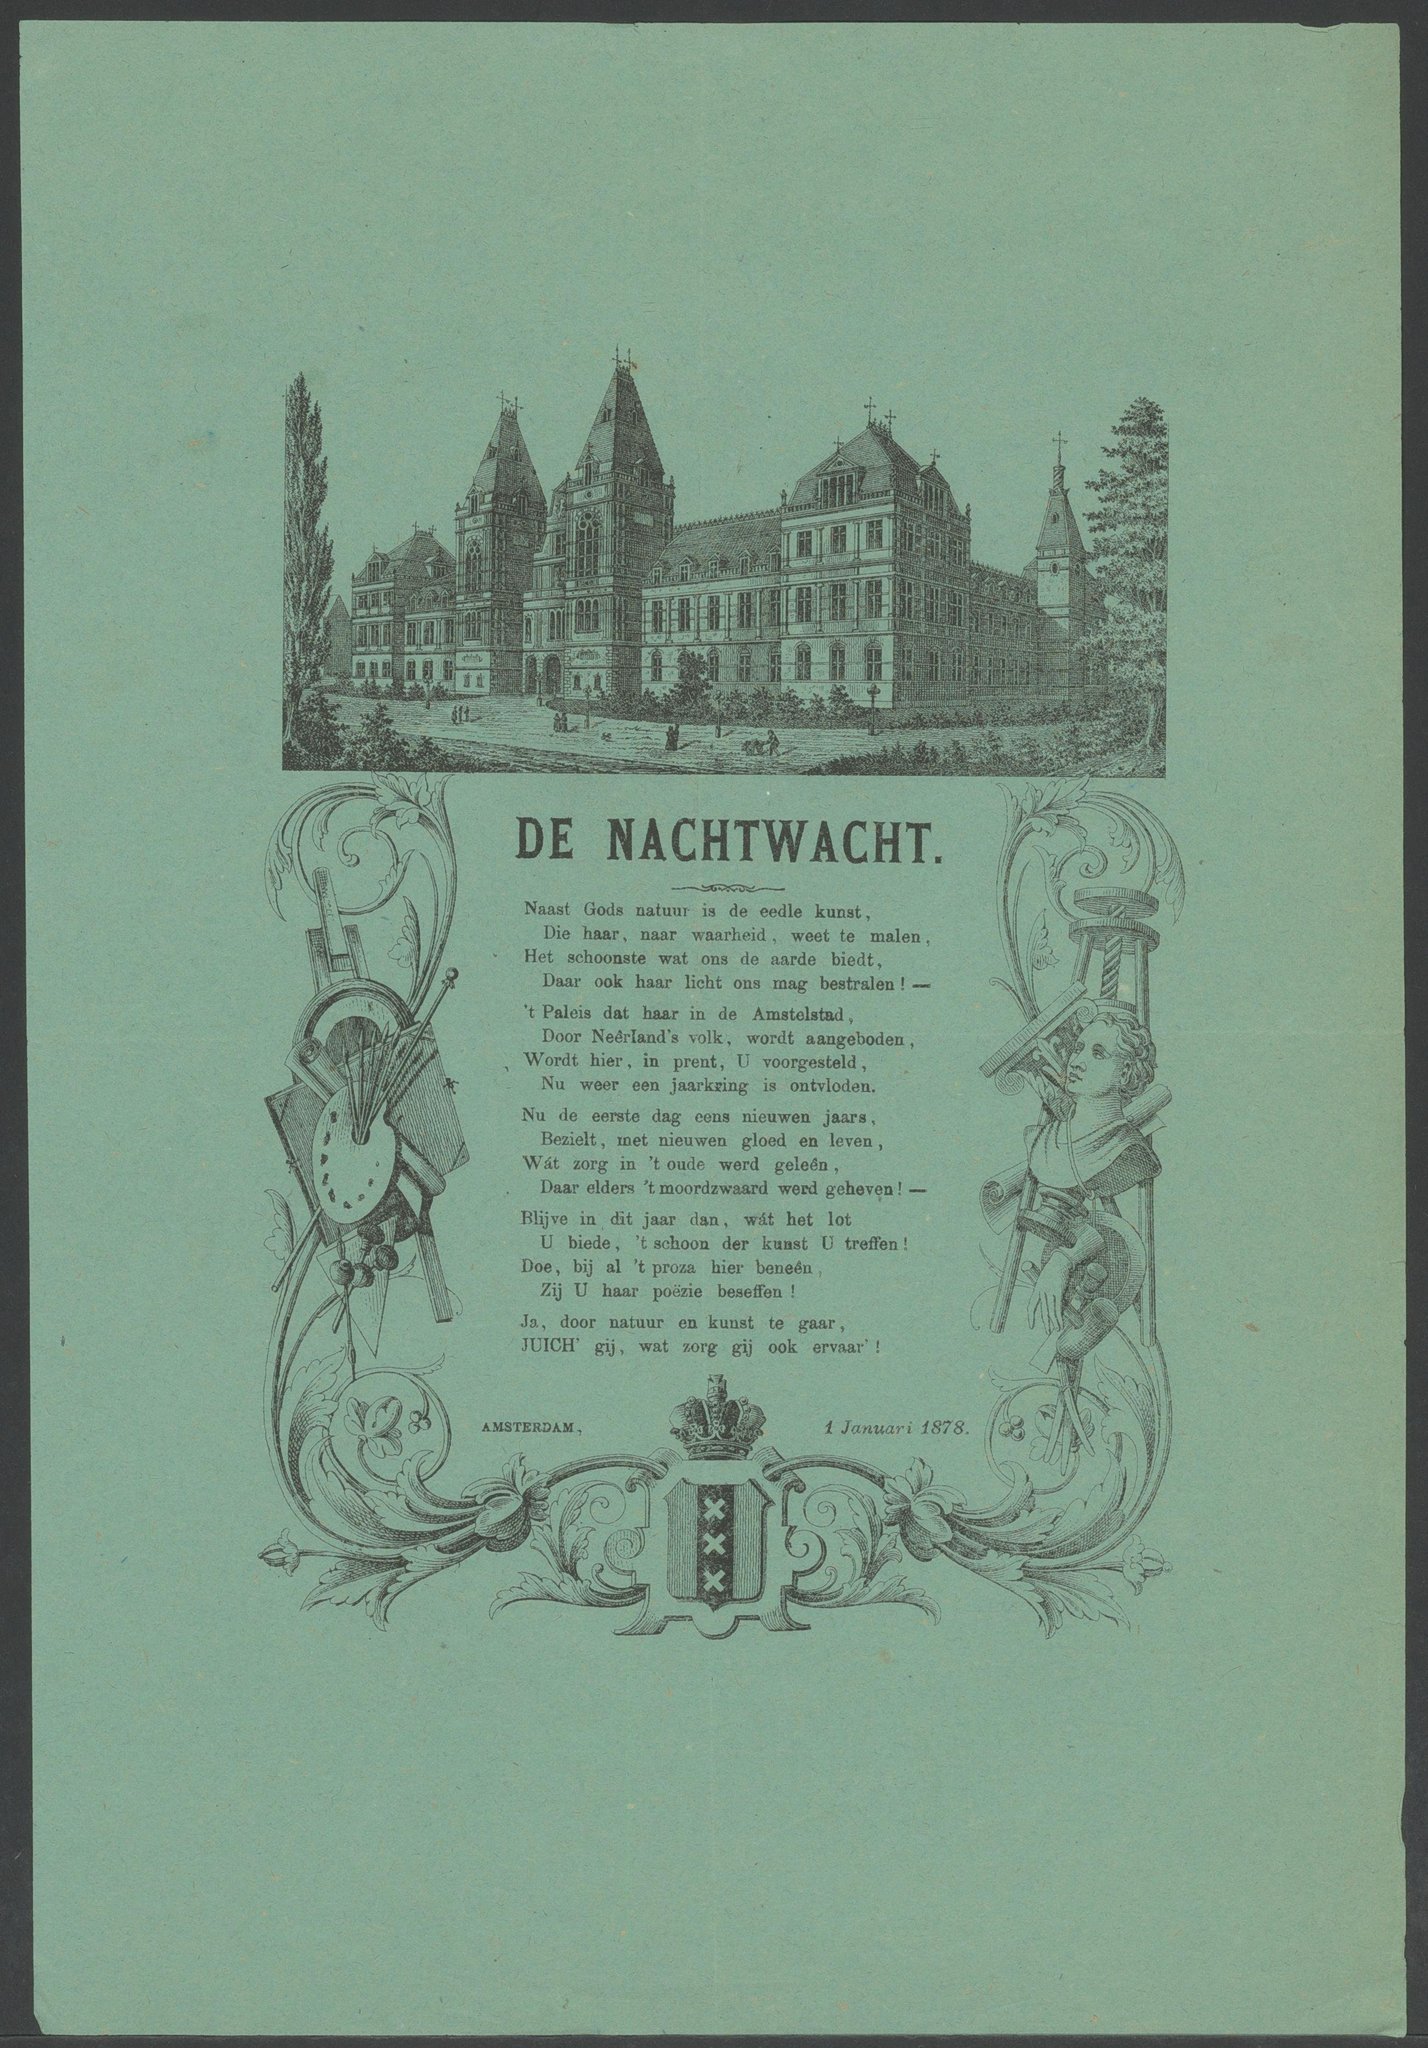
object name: print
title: Nieuwjaarswens van de Amsterdamse nachtwacht voor het jaar 1878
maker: Anonymous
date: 1877-1878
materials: paper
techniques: letterpress printing, engraving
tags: night patrol, permanent exhibition, museum, amsterdam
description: Nieuwjaarswens van de Amsterdamse nachtwacht (ratelwacht) voor het jaar 1878. Bovenaan het Rijksmuseum Amsterdam. Centraal een gedicht, aan weerszijde attributen van kunstenaars en onderaan het stadswapen van Amsterdam. Onderwerpsrubrieken binnen de Atlas Zeden en Gewoonten: Zeden en gewoonten in engeren zin, Volksleven, Volksbladen, Nieuwjaars- en Kerstwenschen, Amsterdam.